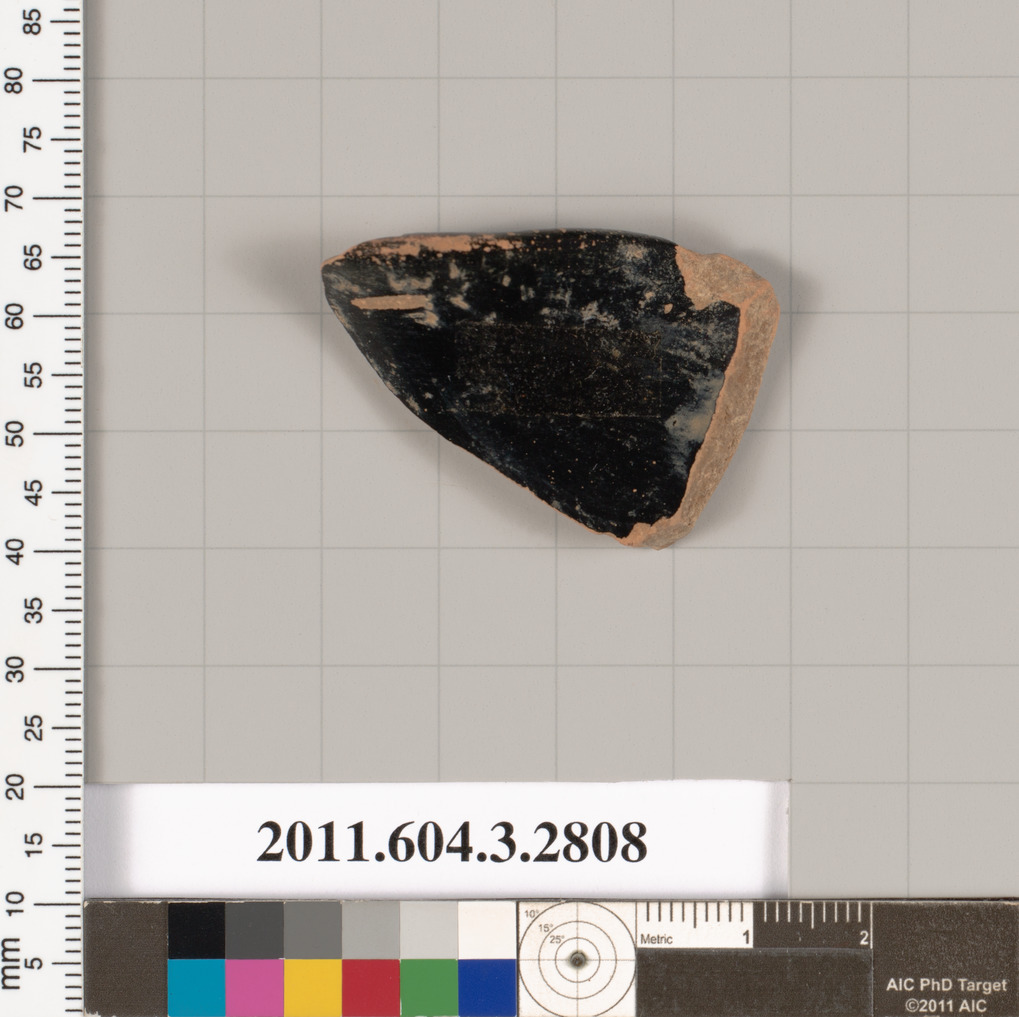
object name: chou fragment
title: Terracotta fragment of an oinochoe: chous (jug)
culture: greek, attic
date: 500-401 BCE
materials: terracotta